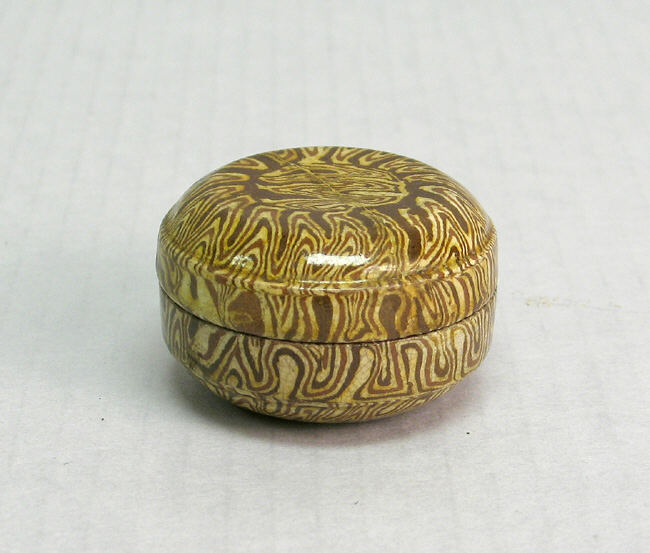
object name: box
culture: chinese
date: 1736-1795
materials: pottery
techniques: glazing